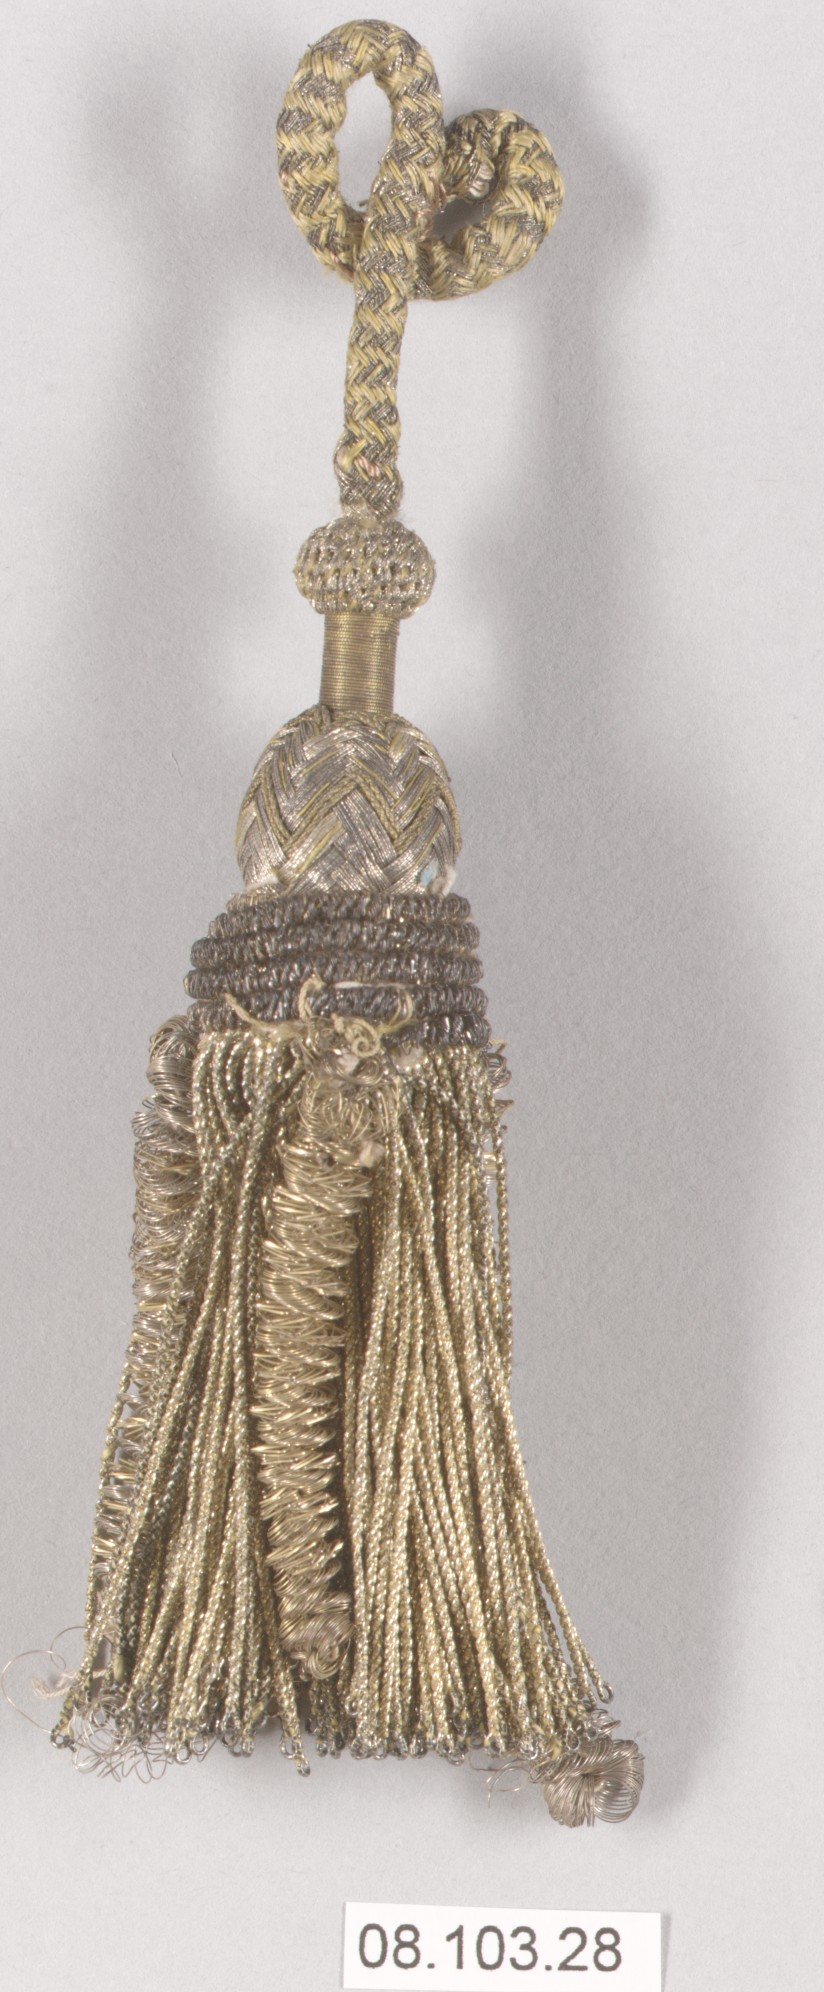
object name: tassel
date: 1701-1900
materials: metal thread